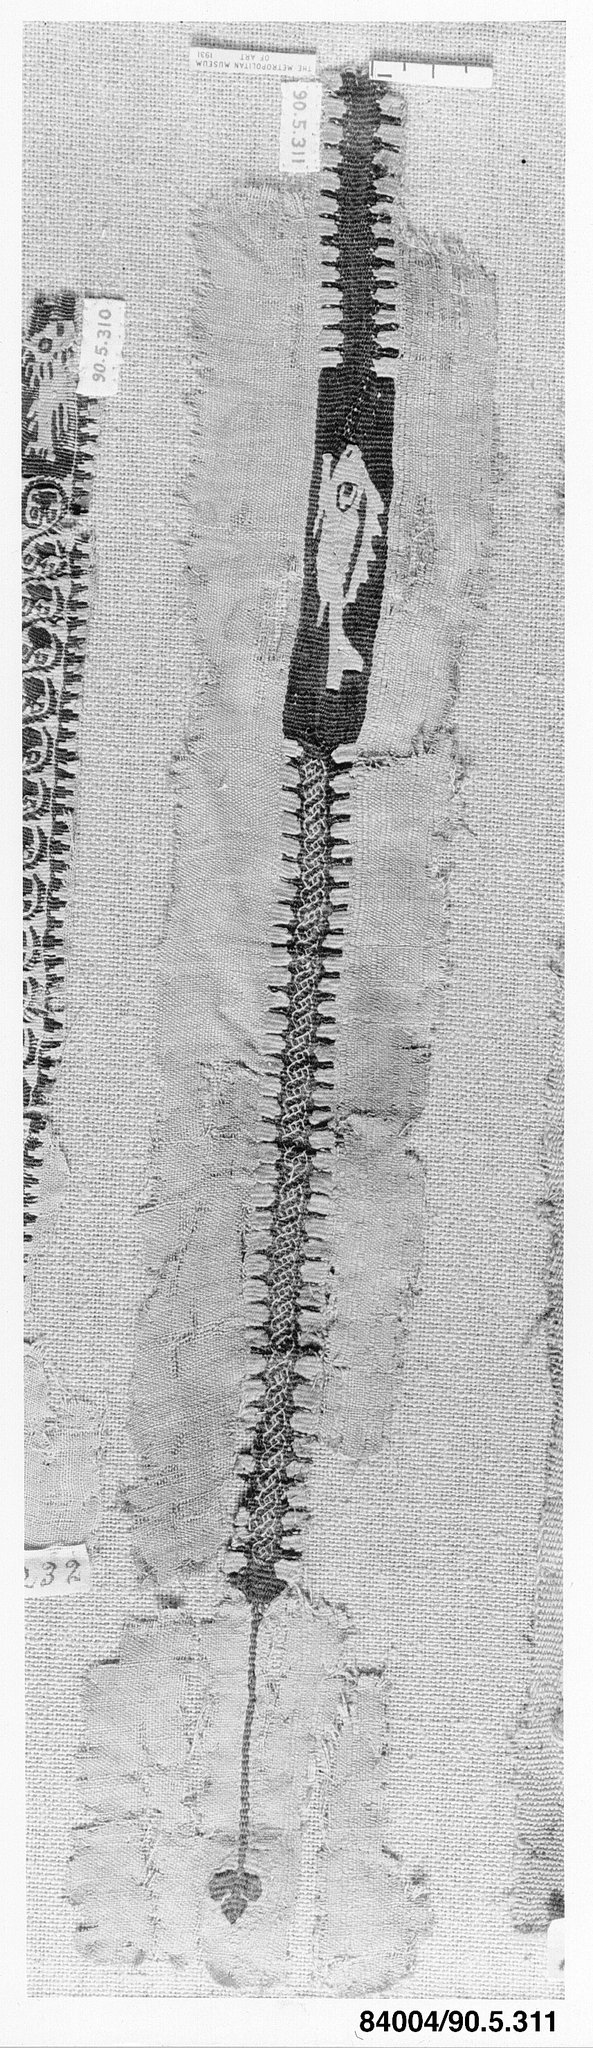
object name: textile fragment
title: Fragment if a Tunic with a Fish Motif Shoulder Band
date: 301-500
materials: linen, wool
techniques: weave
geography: egypt